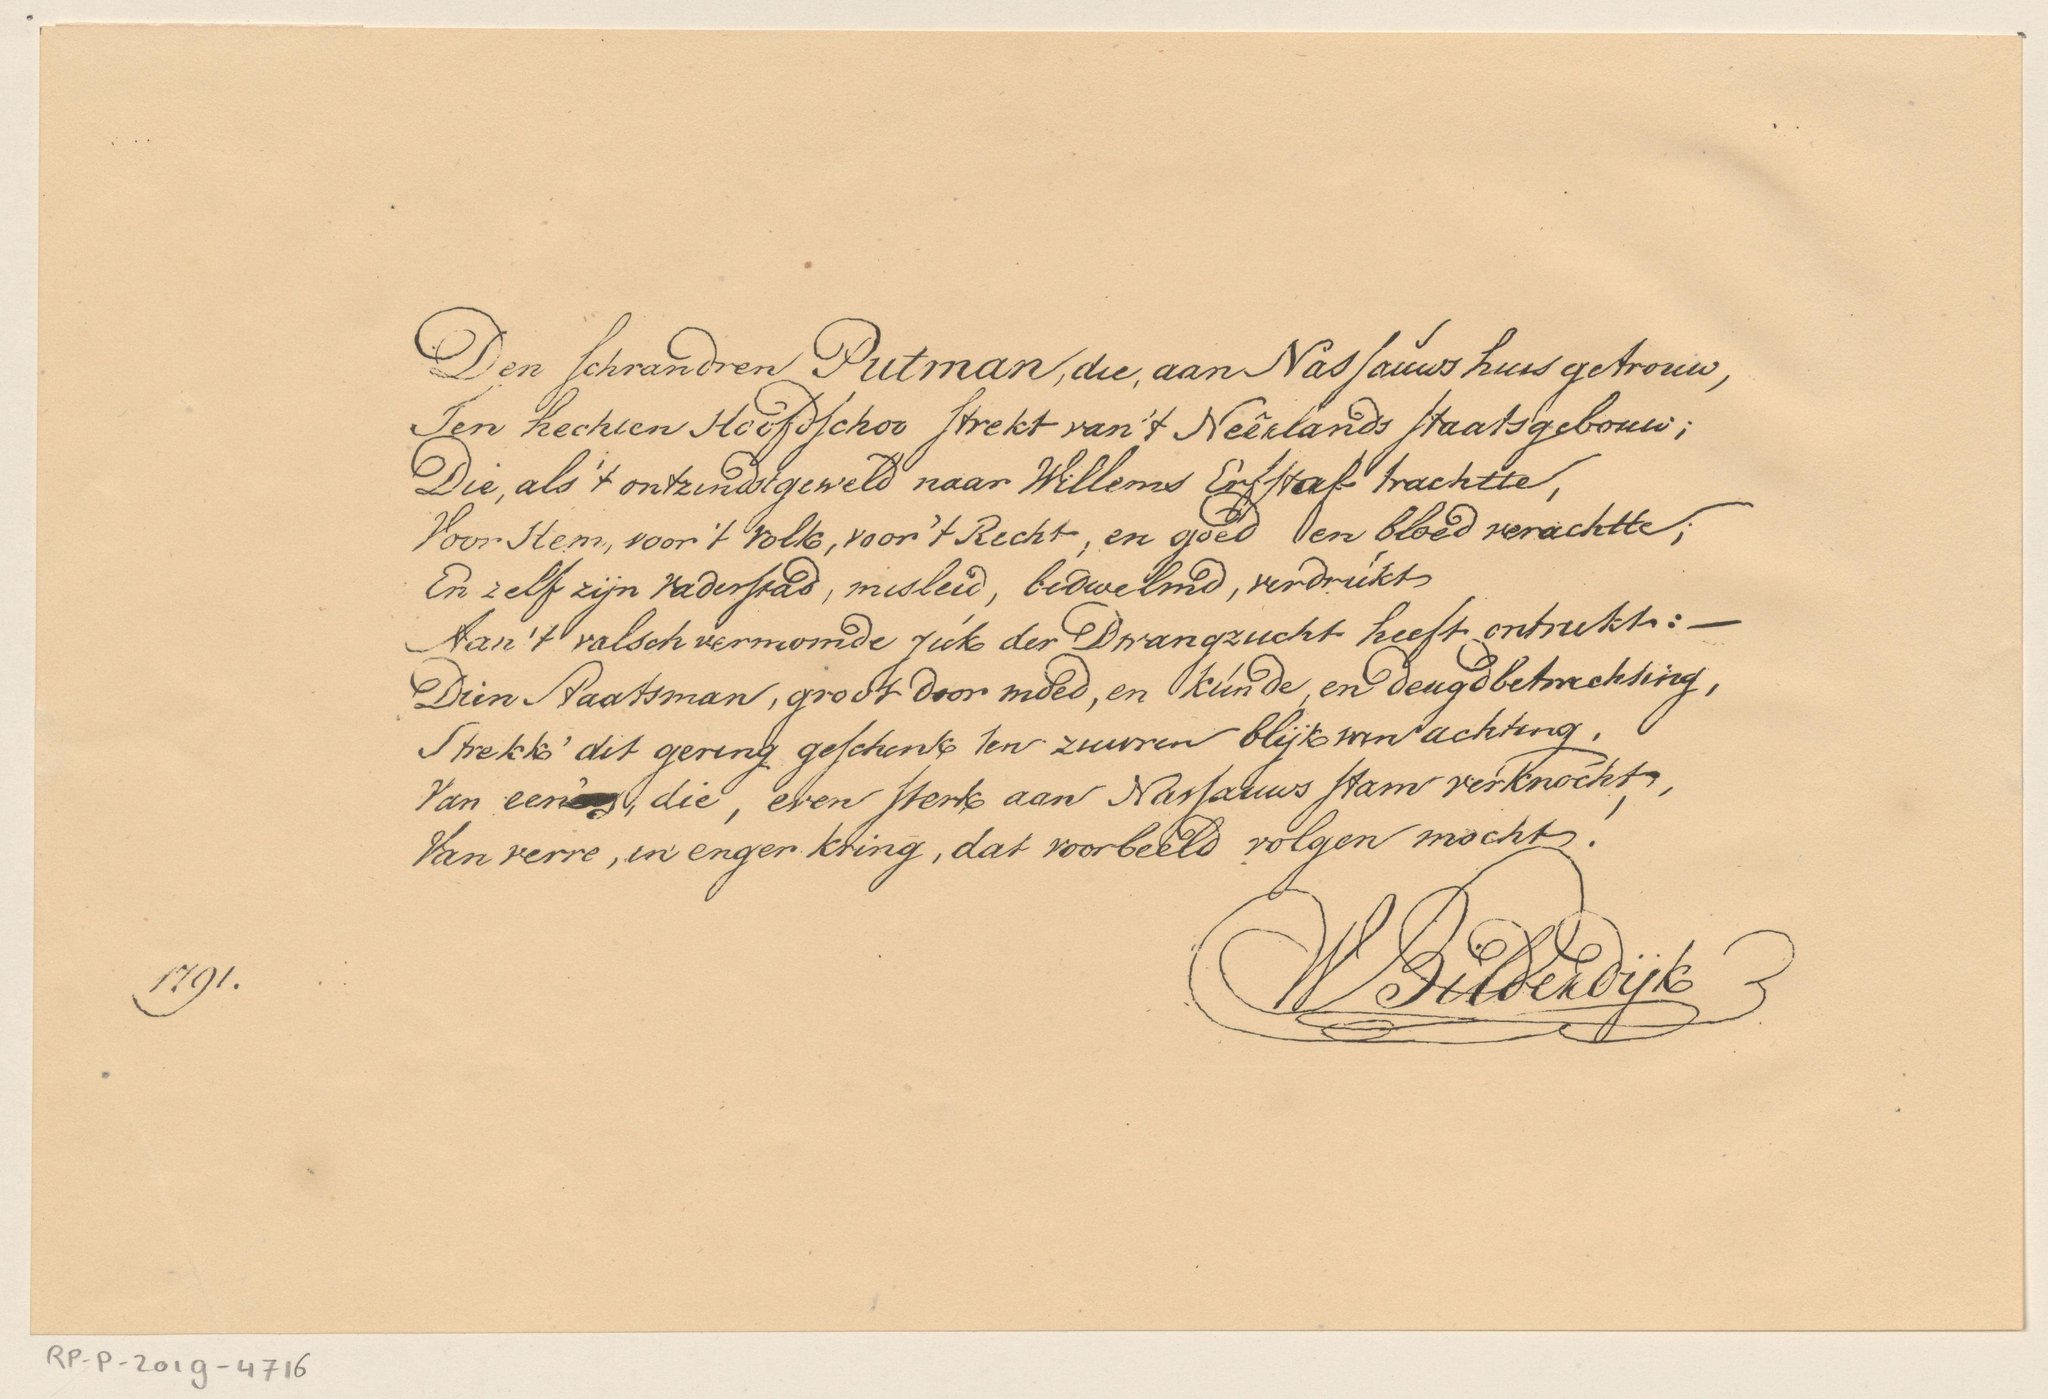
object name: print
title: Lofdicht op Everhard Herman Putman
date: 1800-1899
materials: paper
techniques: lithograph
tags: deventer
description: Gedicht door de prinsgezinde schrijver Willem Bilderdijk aan mede-orangist Everhard Herman Putman, burgemeester van Deventer.